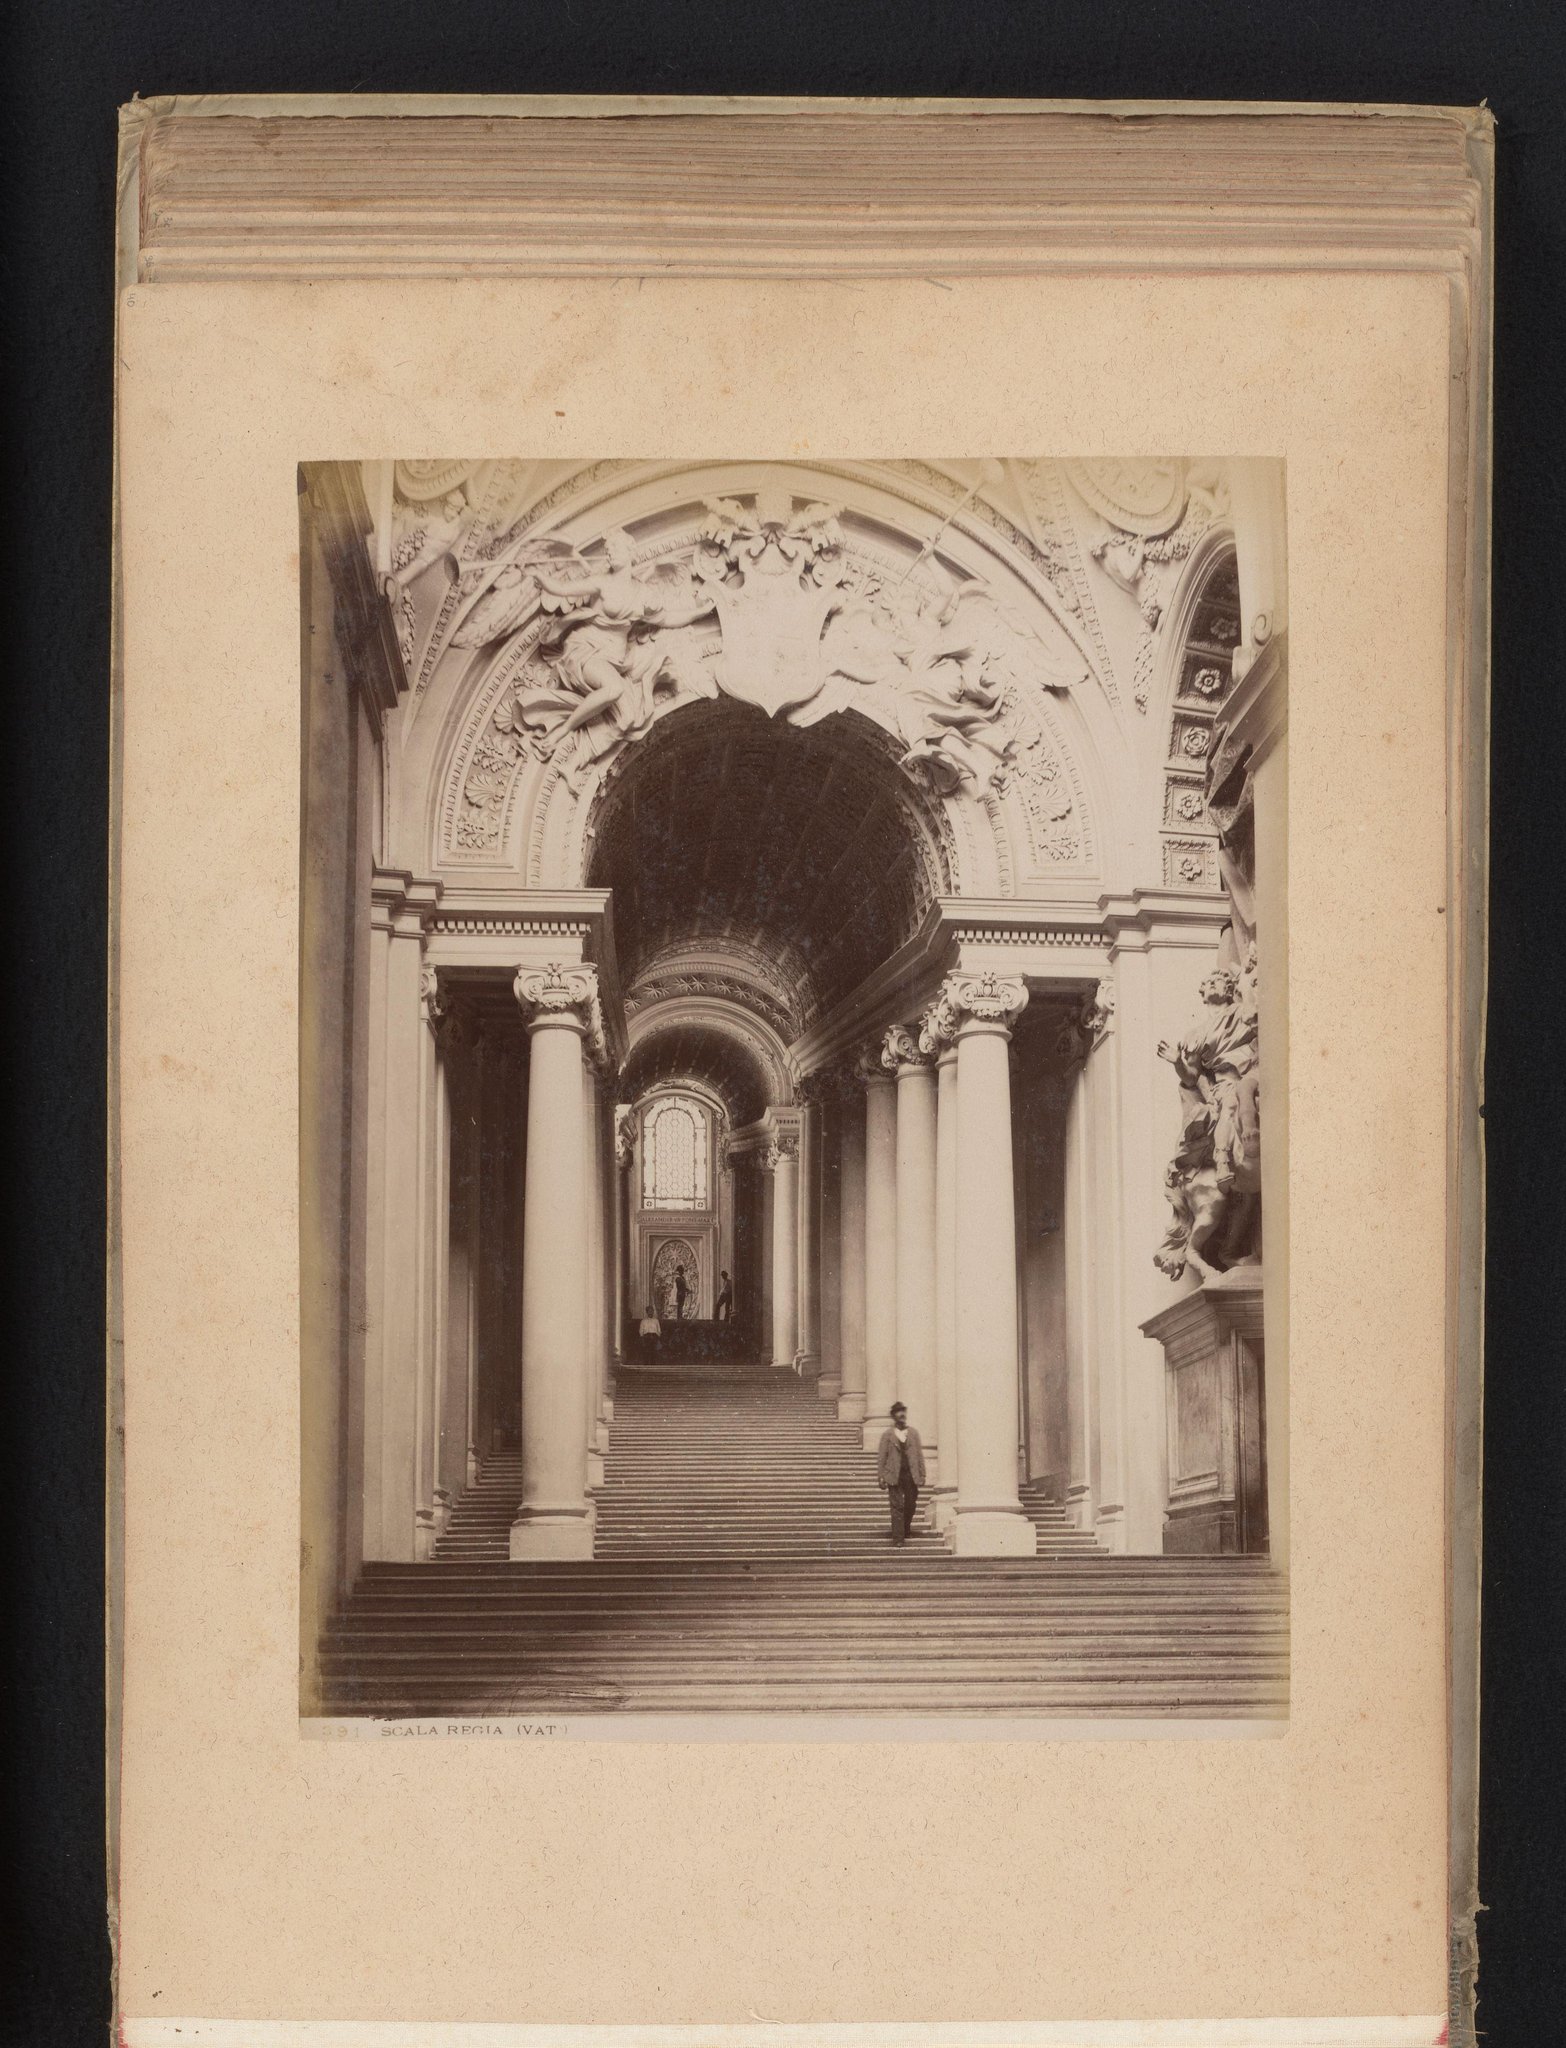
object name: album leaf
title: Gezicht op de Scala Regia in Vaticaanstad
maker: Anonymous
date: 1870-1895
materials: cardboard, photographic support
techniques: albumen print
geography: vatican city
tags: staircase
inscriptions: inscription: ‘391 SCALA REGIA (VAT)’